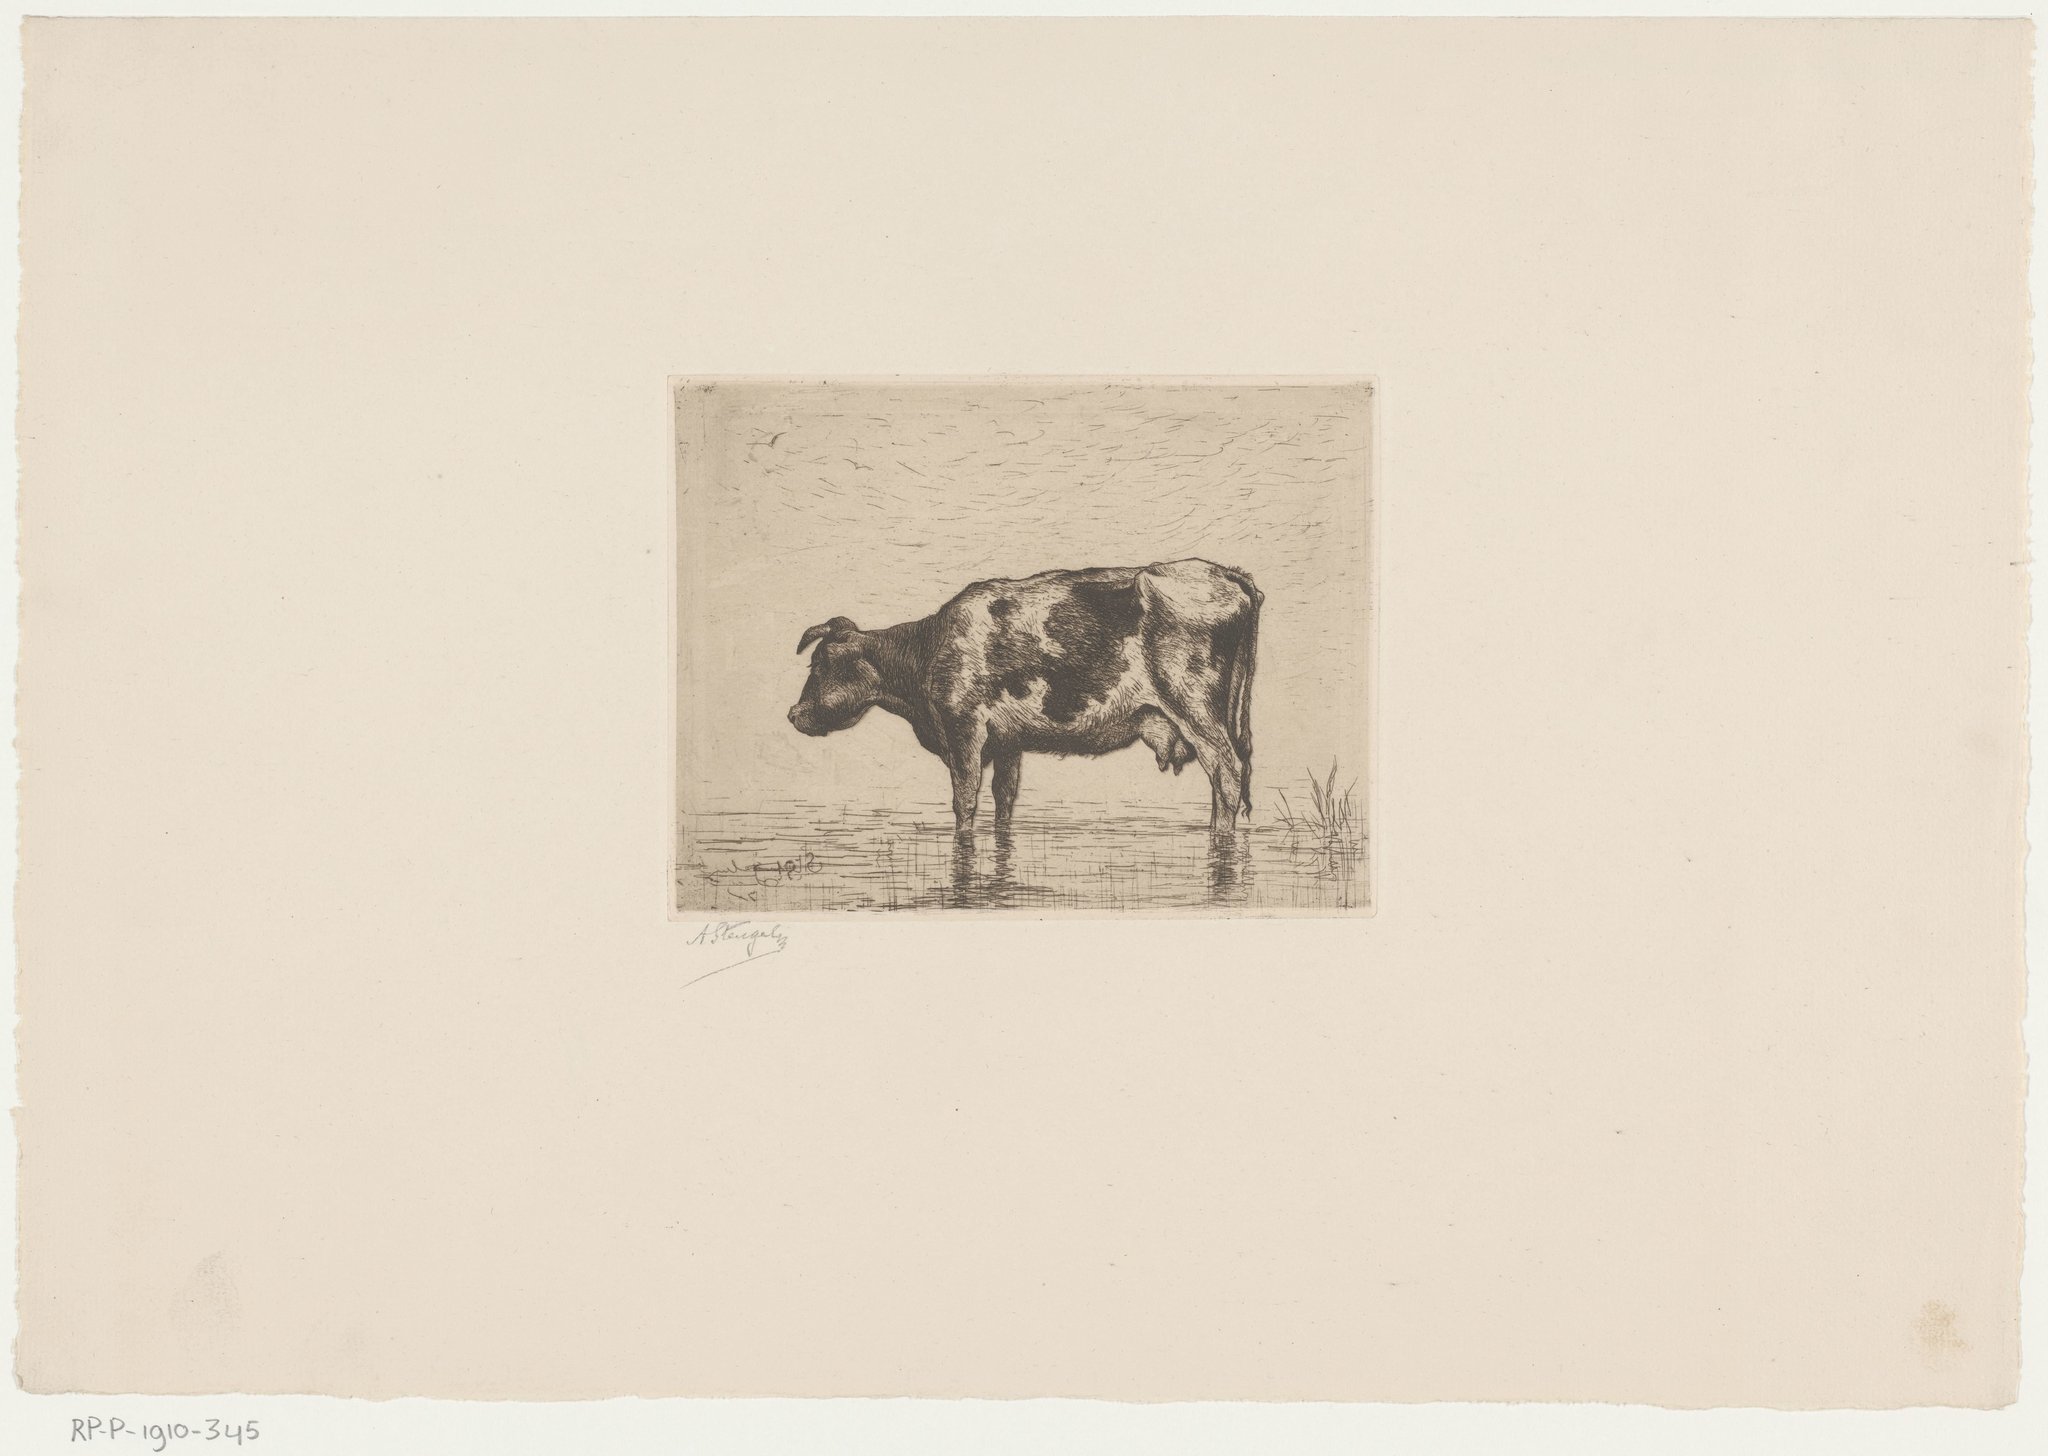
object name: print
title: Koe in een plas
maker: alphonse stengelin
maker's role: painter, print maker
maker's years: 1852-1938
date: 1862-1910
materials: paper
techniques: etching, intaglio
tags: cow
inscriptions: collector's mark: Lugt 2228